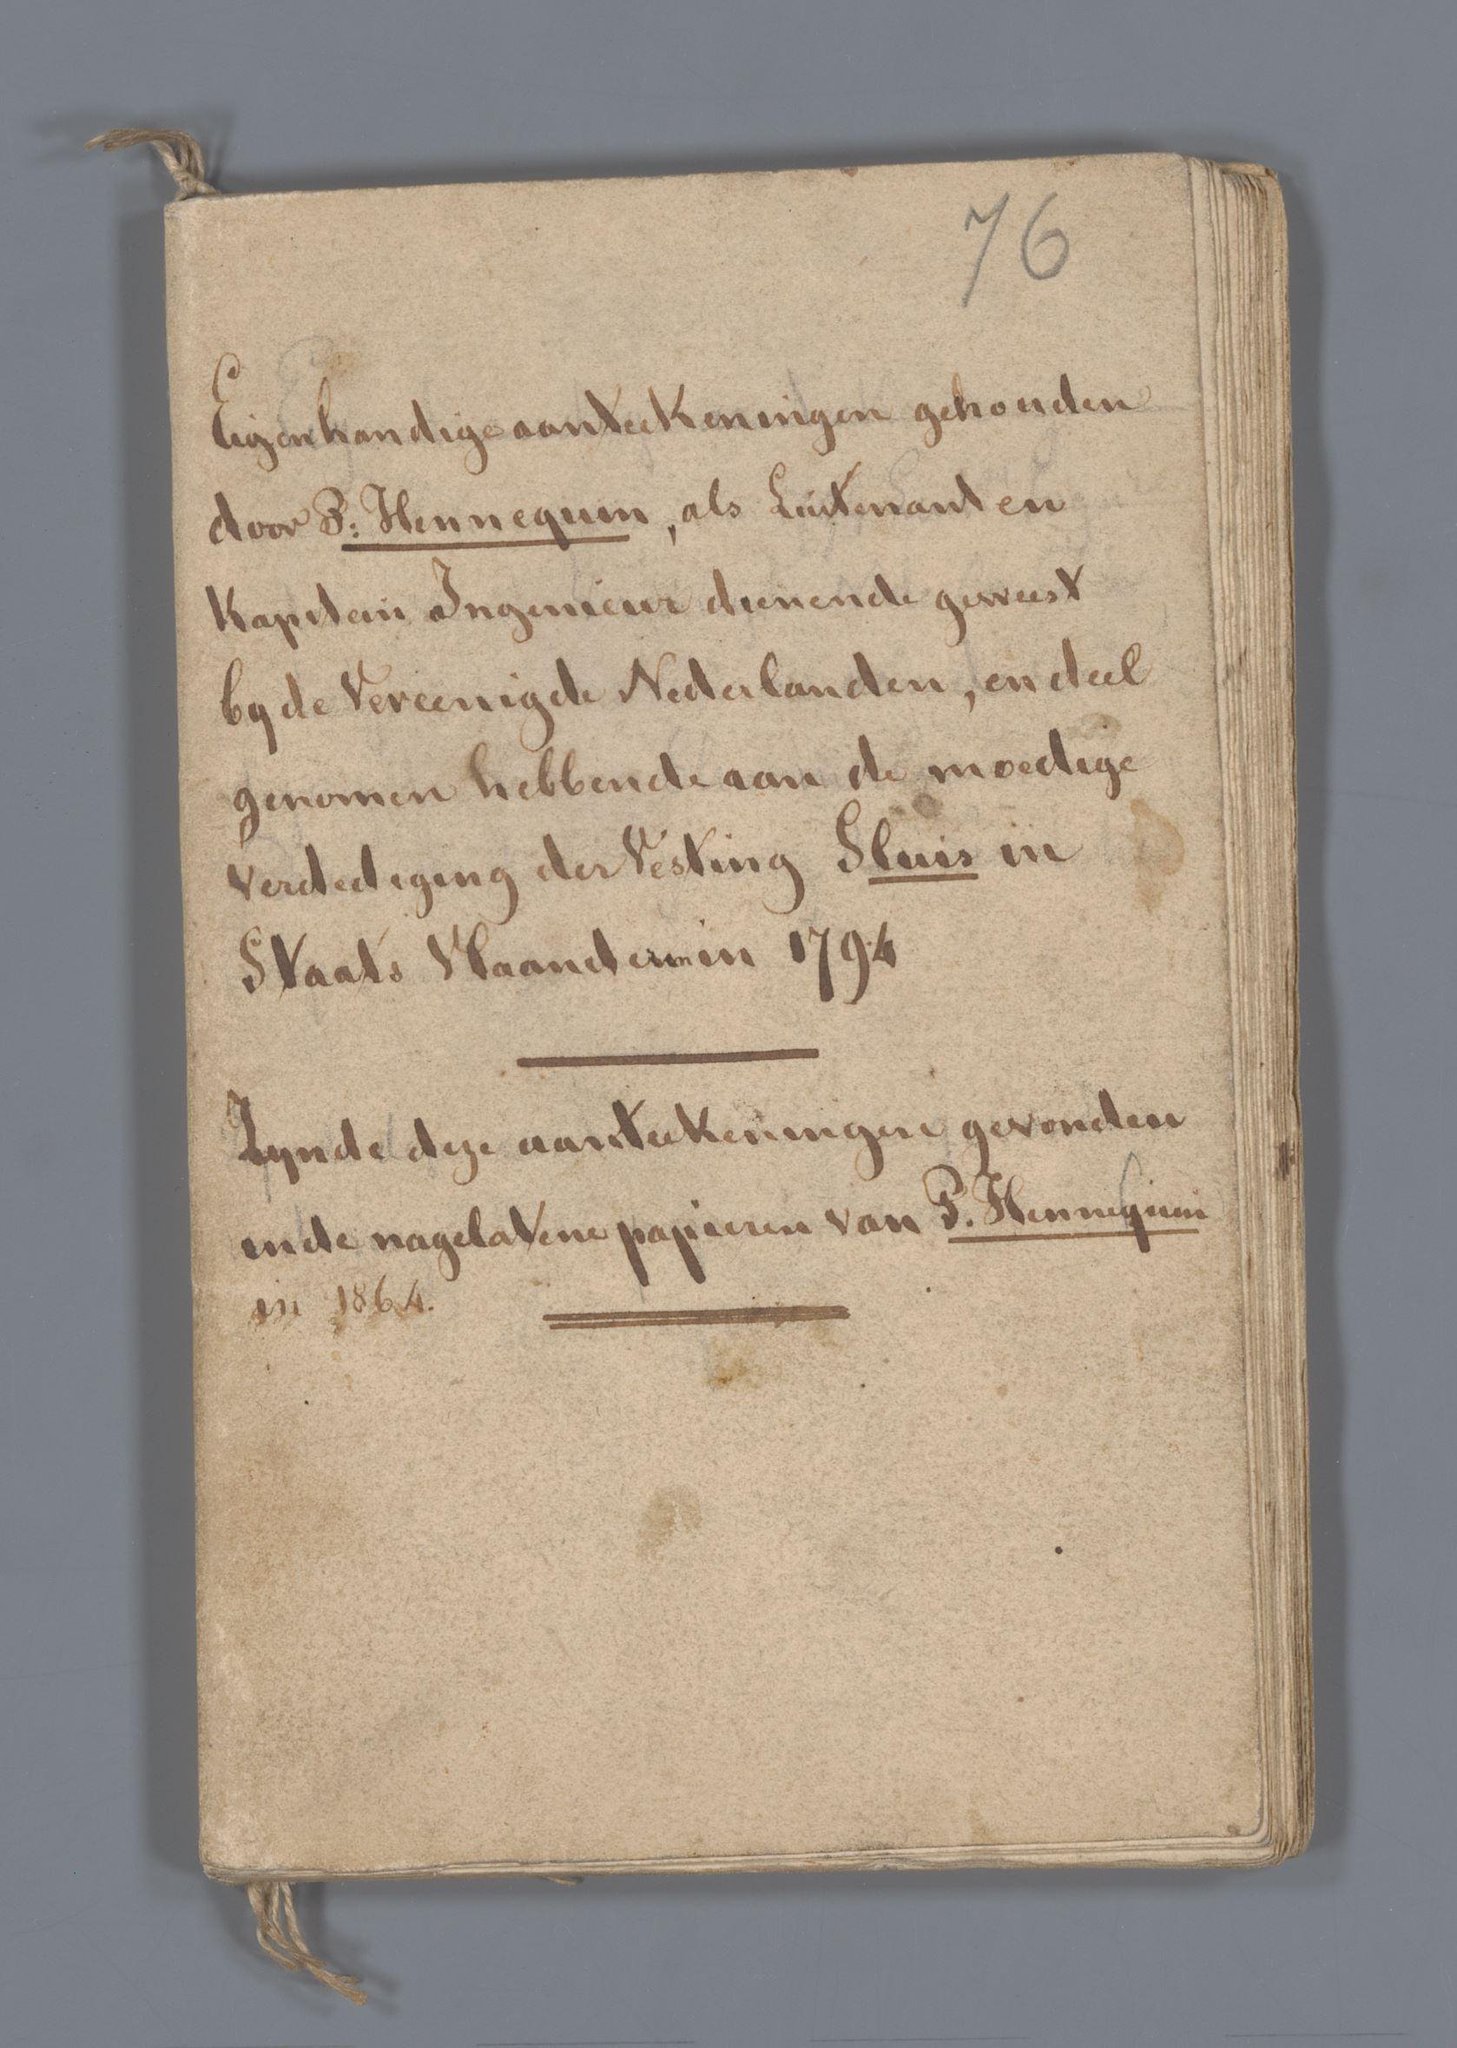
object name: document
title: Eigenhandige aantekeningen gehouden door P. Hennequin, als Luitenant en Kapitein Ingenieur dienende geweest bij de Verenigde Nederlanden,......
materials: ink, paper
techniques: sewing, writing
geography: sluis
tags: pieter hennequin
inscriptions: date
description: Dagboek in handschrift (van P. Hennequin), 56 genummerde pp in omslag in andere hand. Gedateerd; omslag.